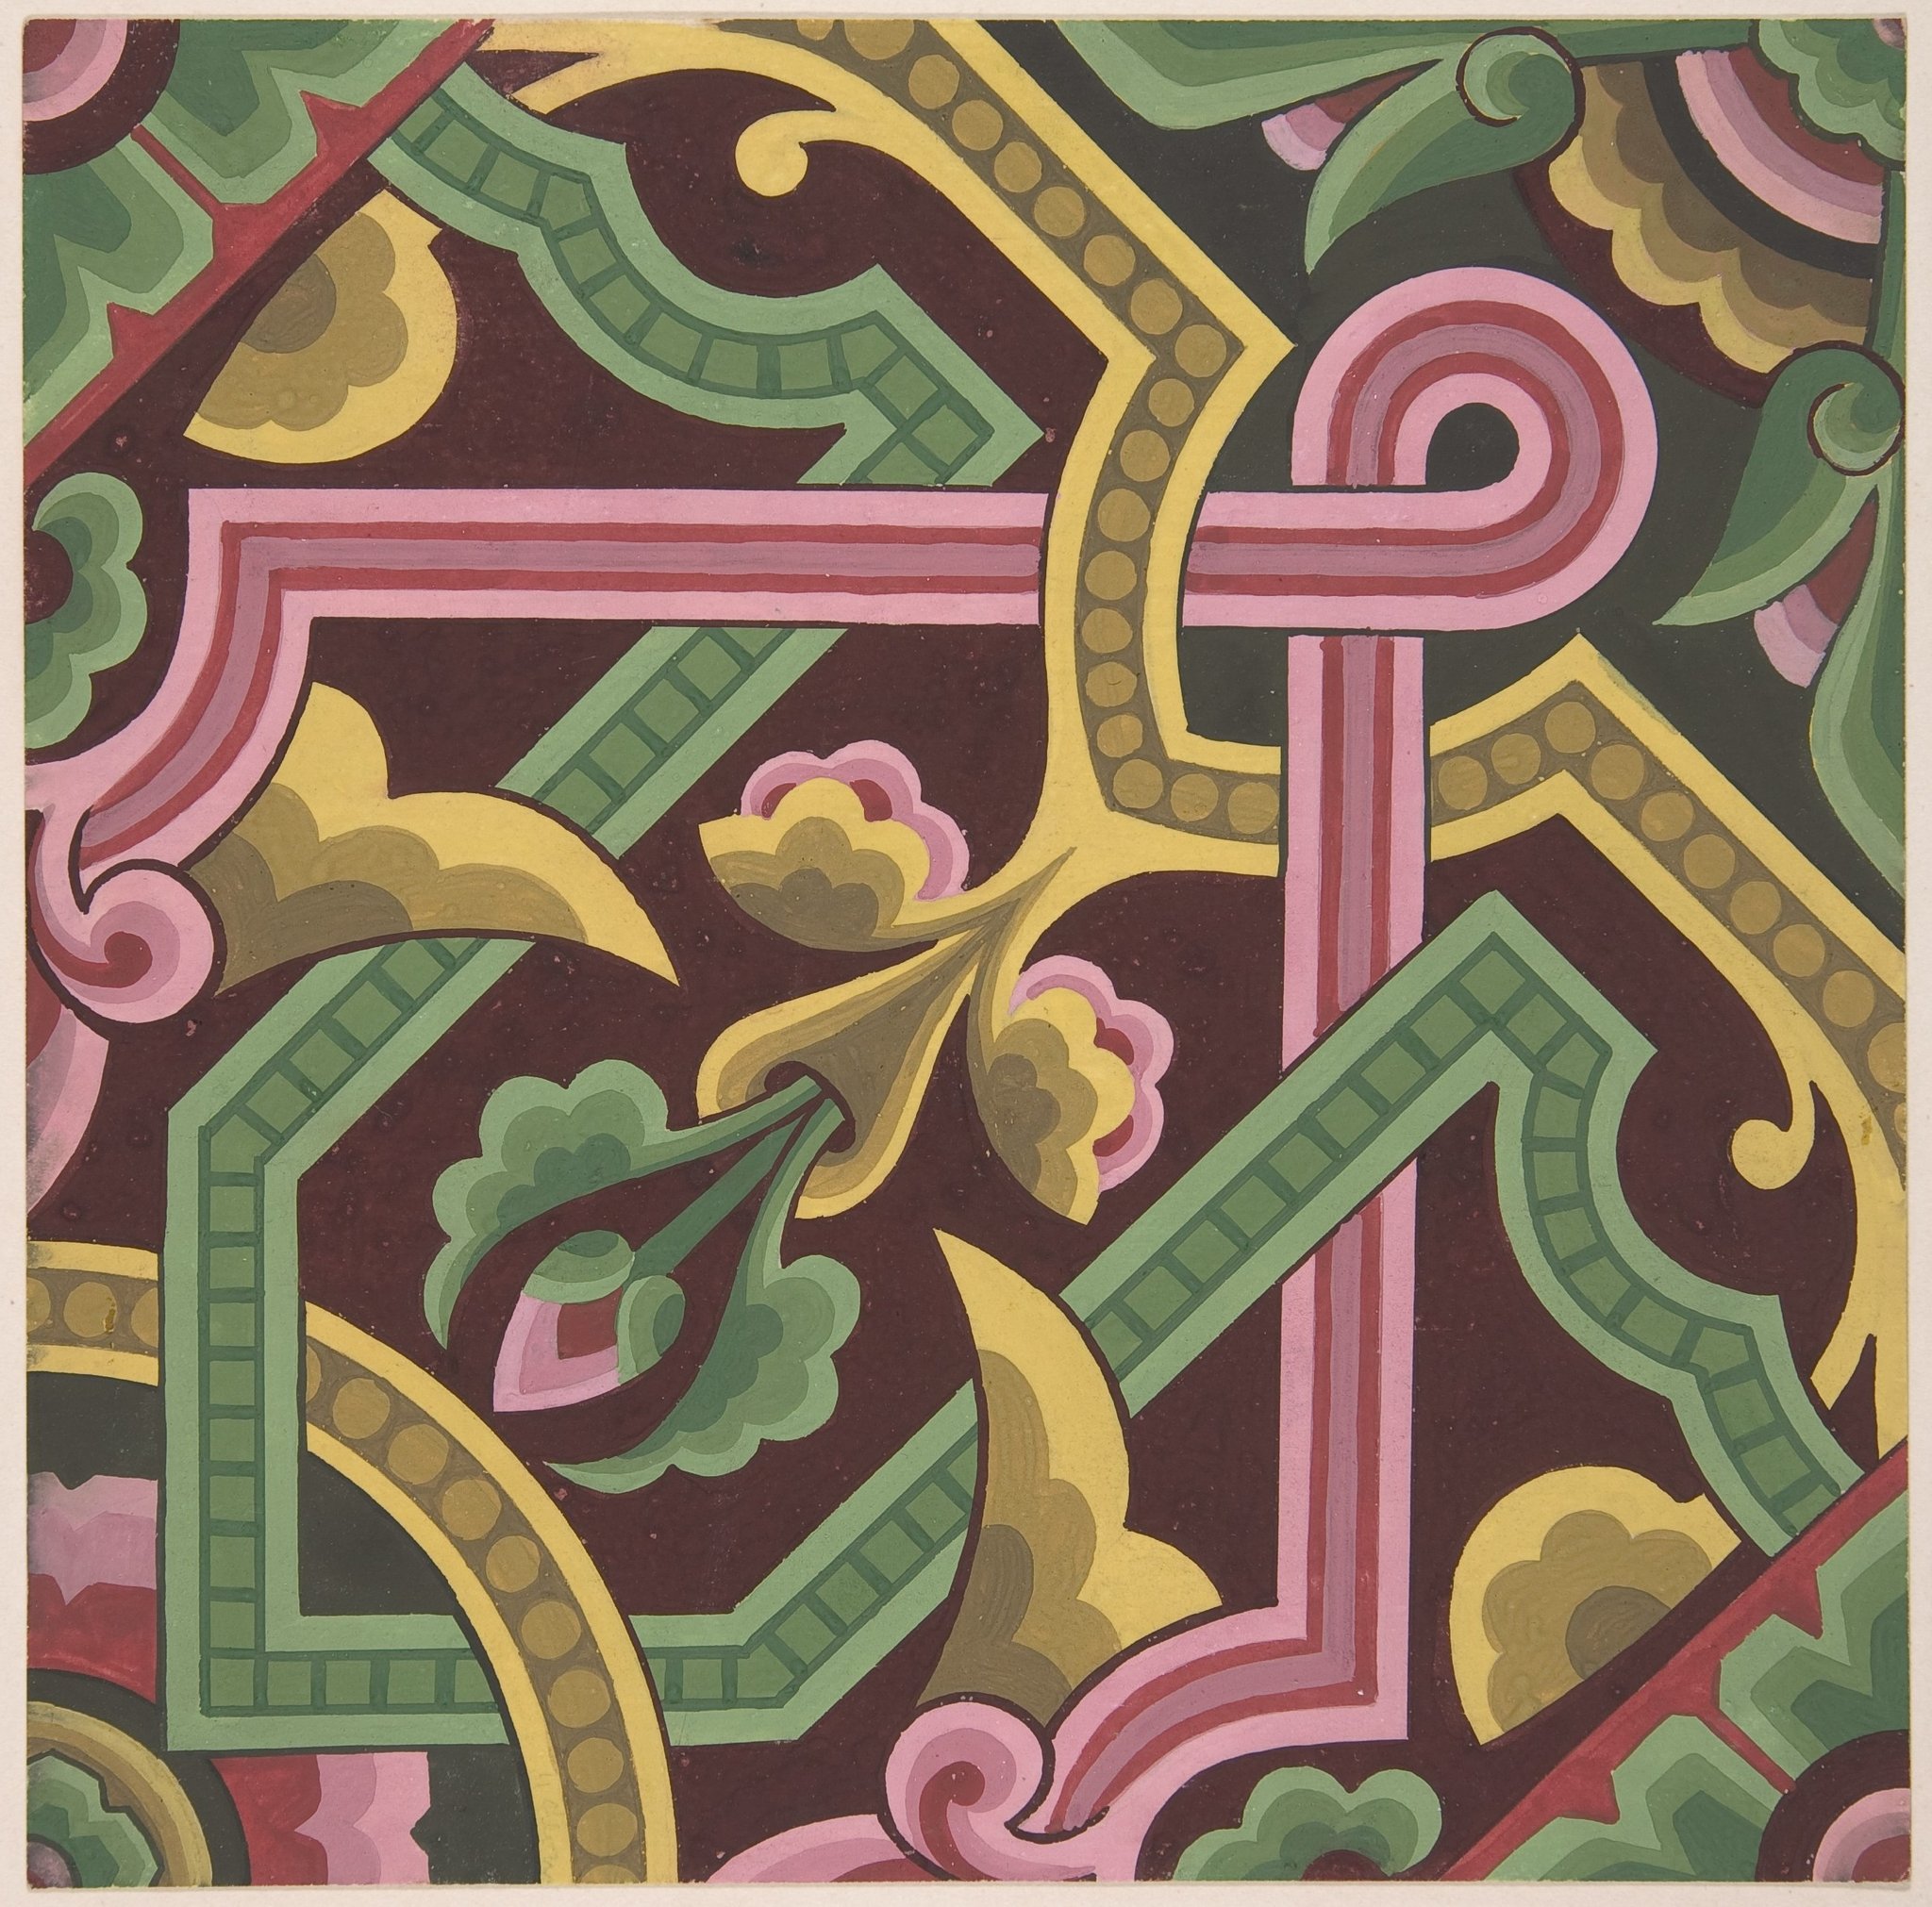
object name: drawing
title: Design drawing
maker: christopher dresser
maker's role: designer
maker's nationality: british, scottish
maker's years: 1834-1904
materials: gouache, graphite, ink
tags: abstraction